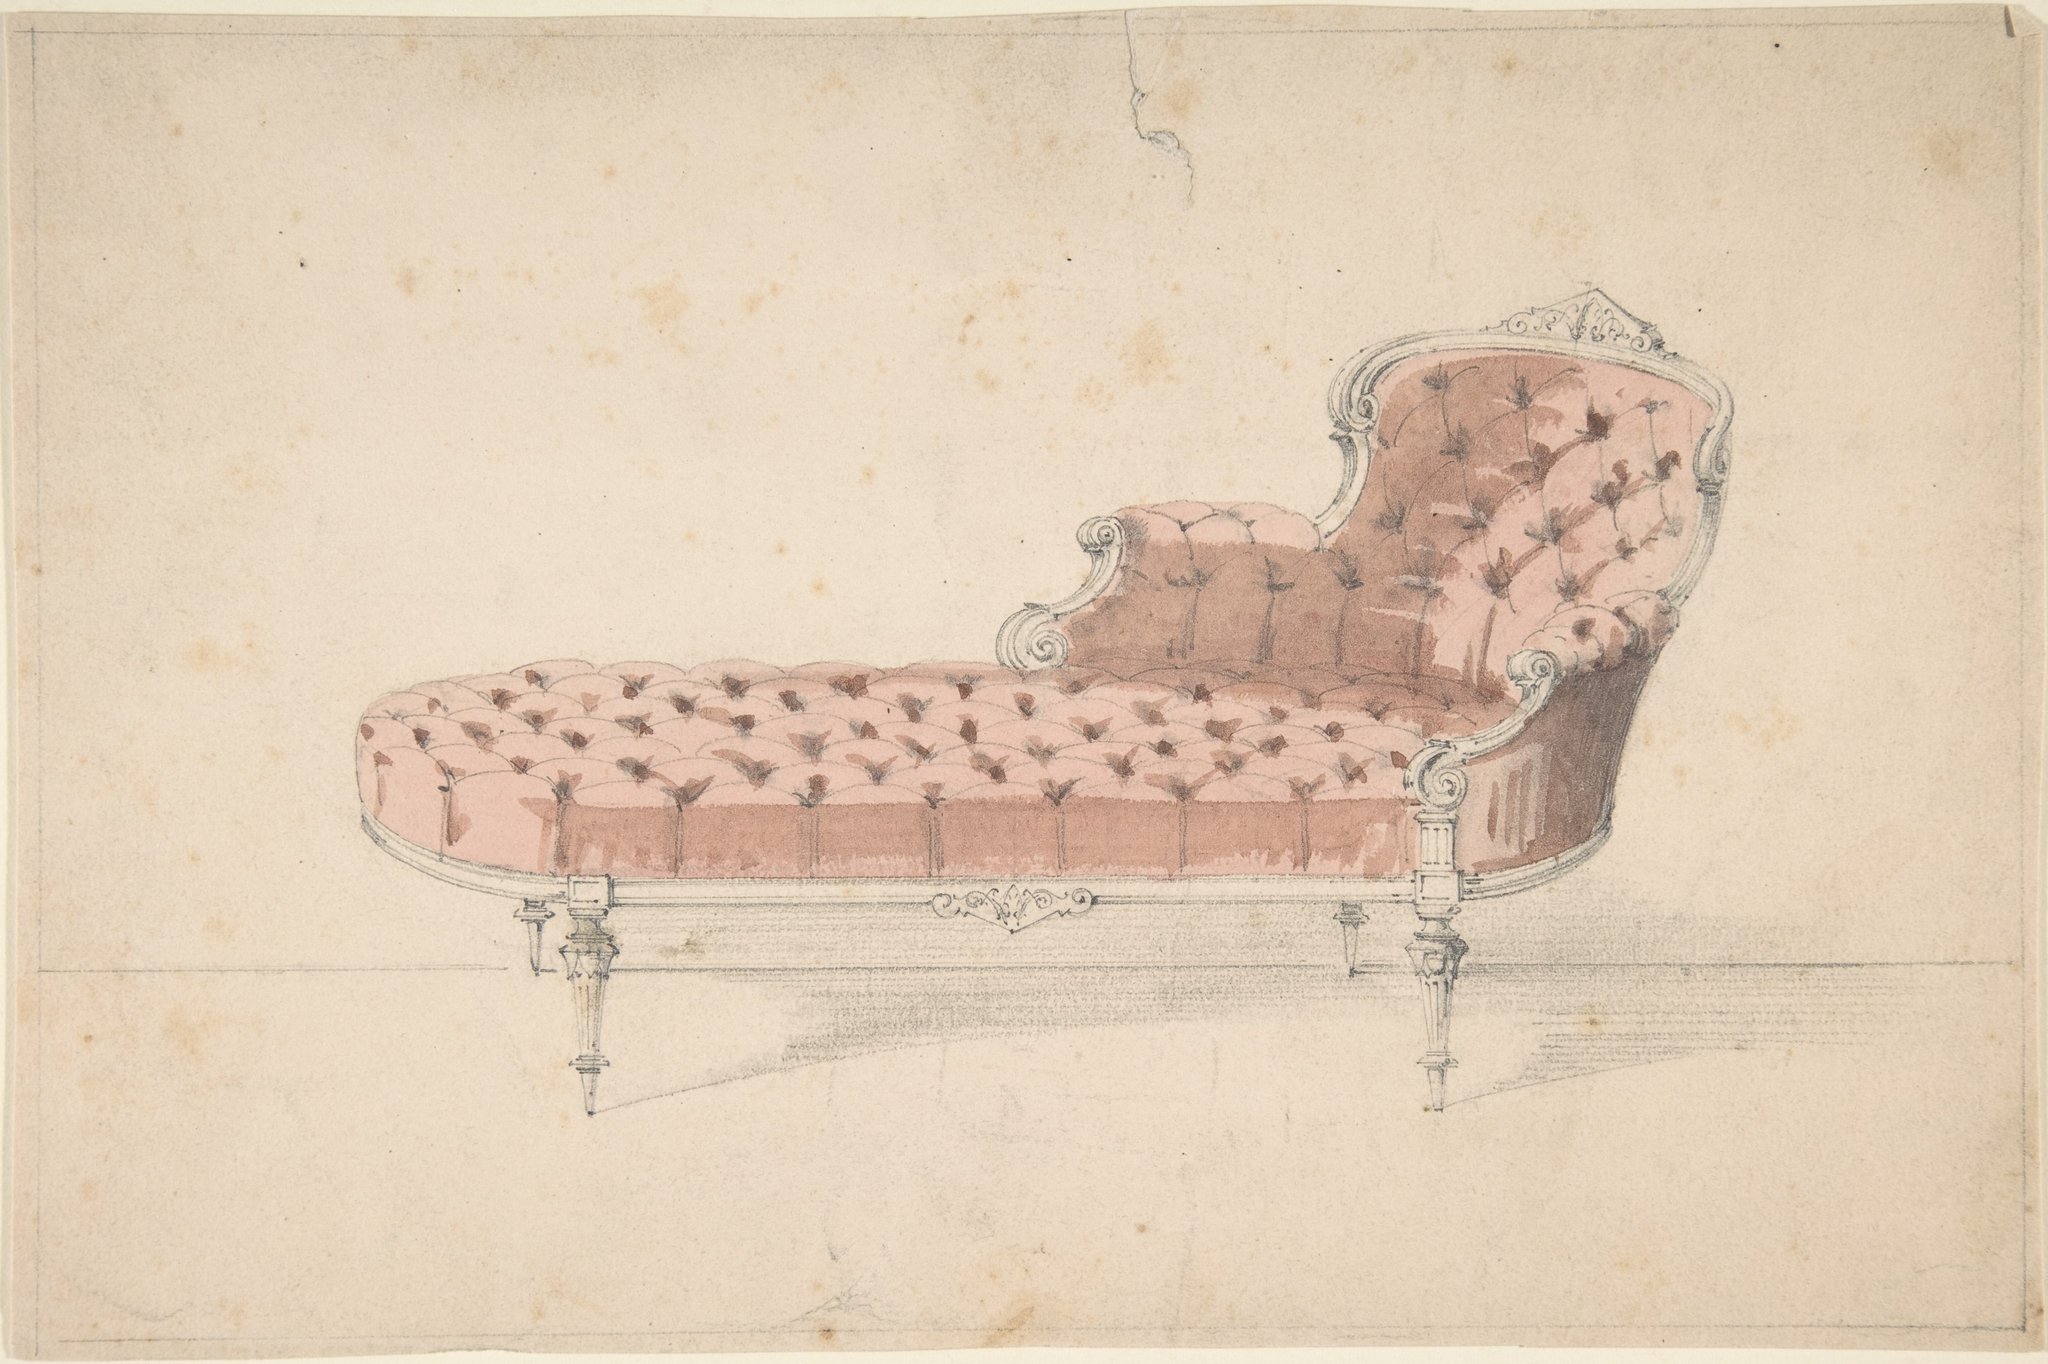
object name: drawing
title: Design for Chaise Lounge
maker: anonymous, french, 19th century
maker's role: artist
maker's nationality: french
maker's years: 1800-1900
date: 1801-1900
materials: graphite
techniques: brush, wash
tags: furniture